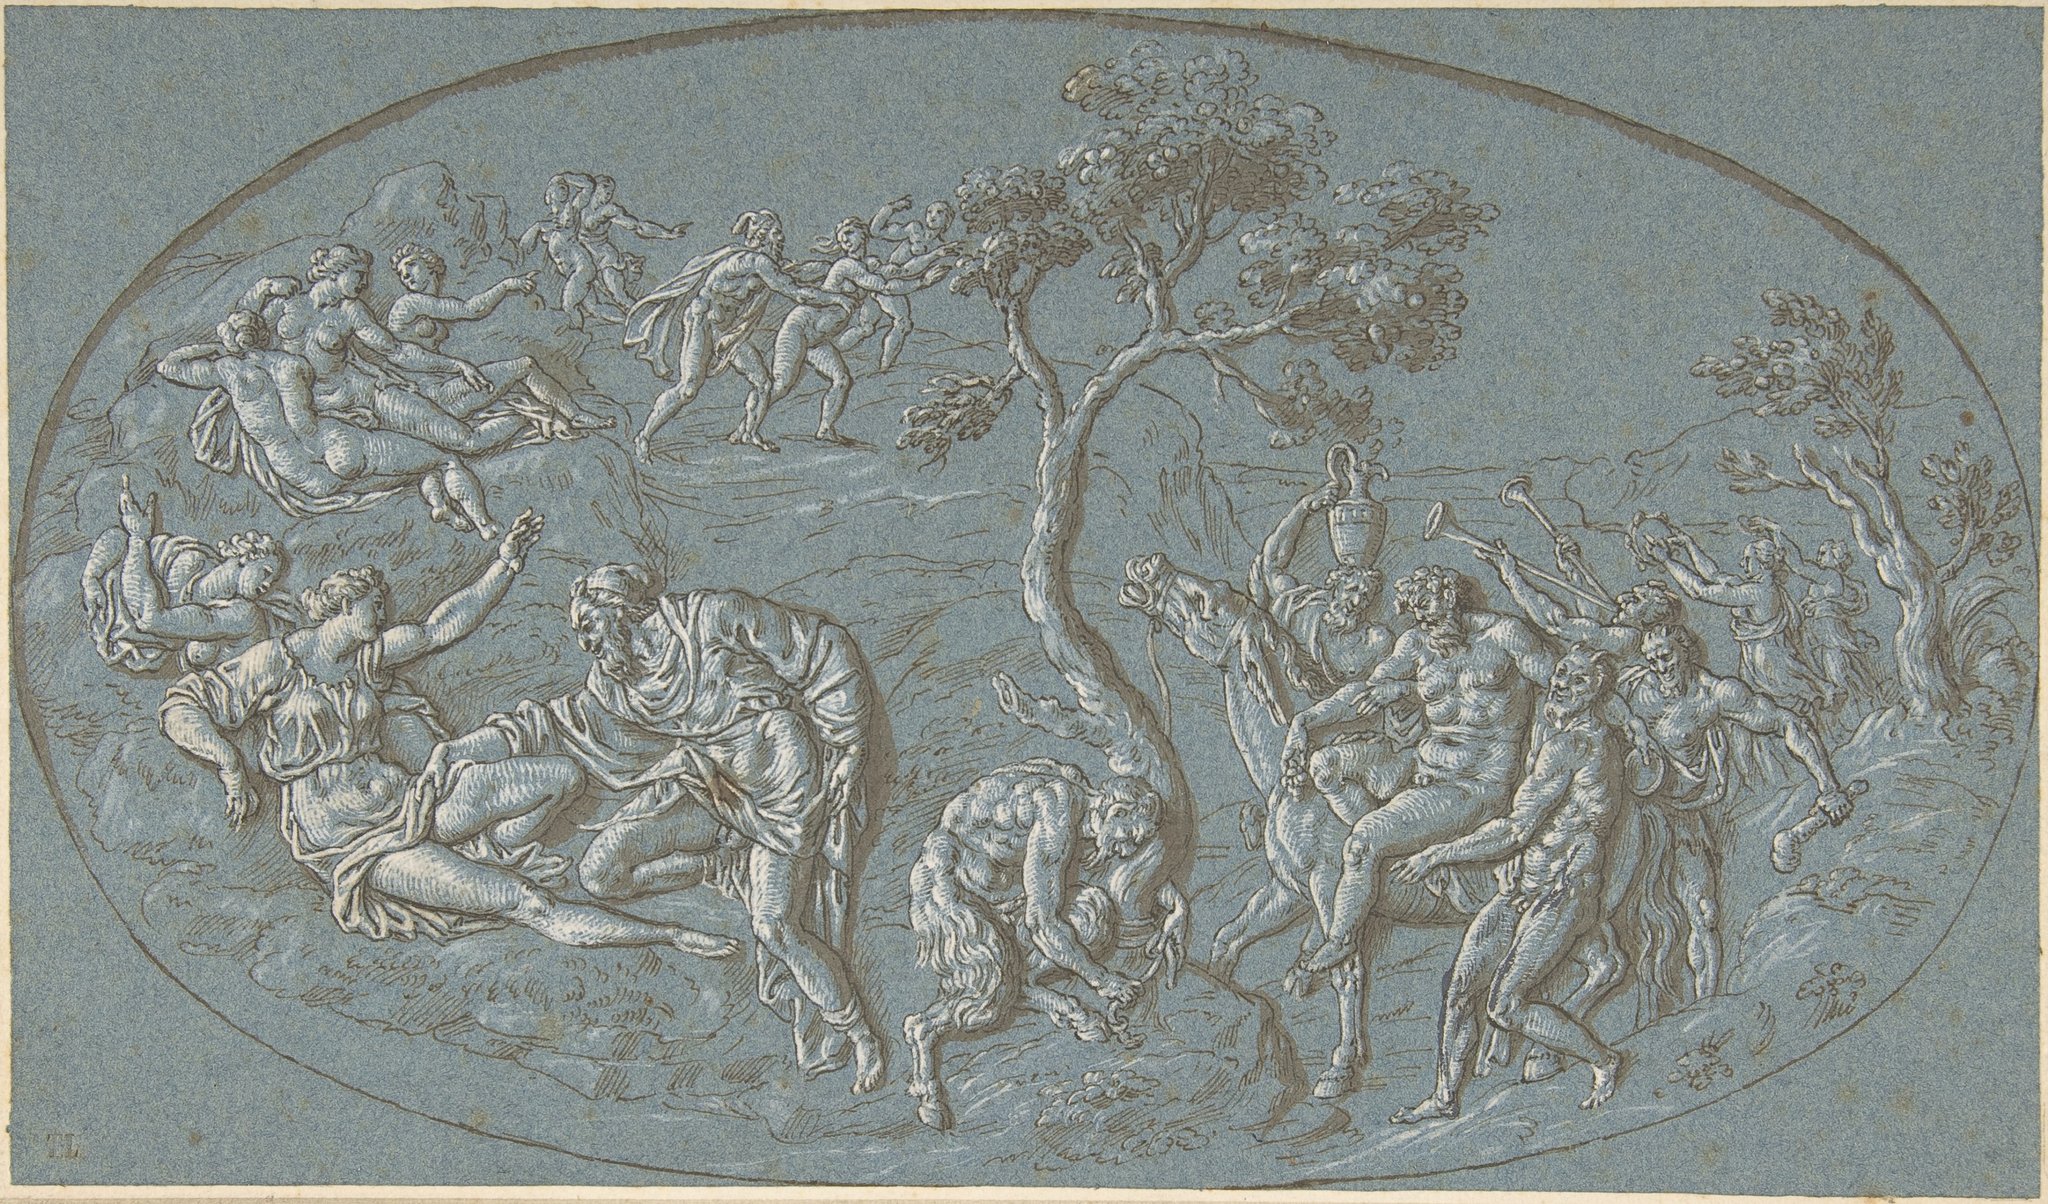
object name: drawing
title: Nymphs And Satyrs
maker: bernard picart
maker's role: artist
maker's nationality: french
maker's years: 1673-1733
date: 1667-1733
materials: ink, paper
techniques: brush, heightening, pen, wash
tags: nymphs,satyrs,trees